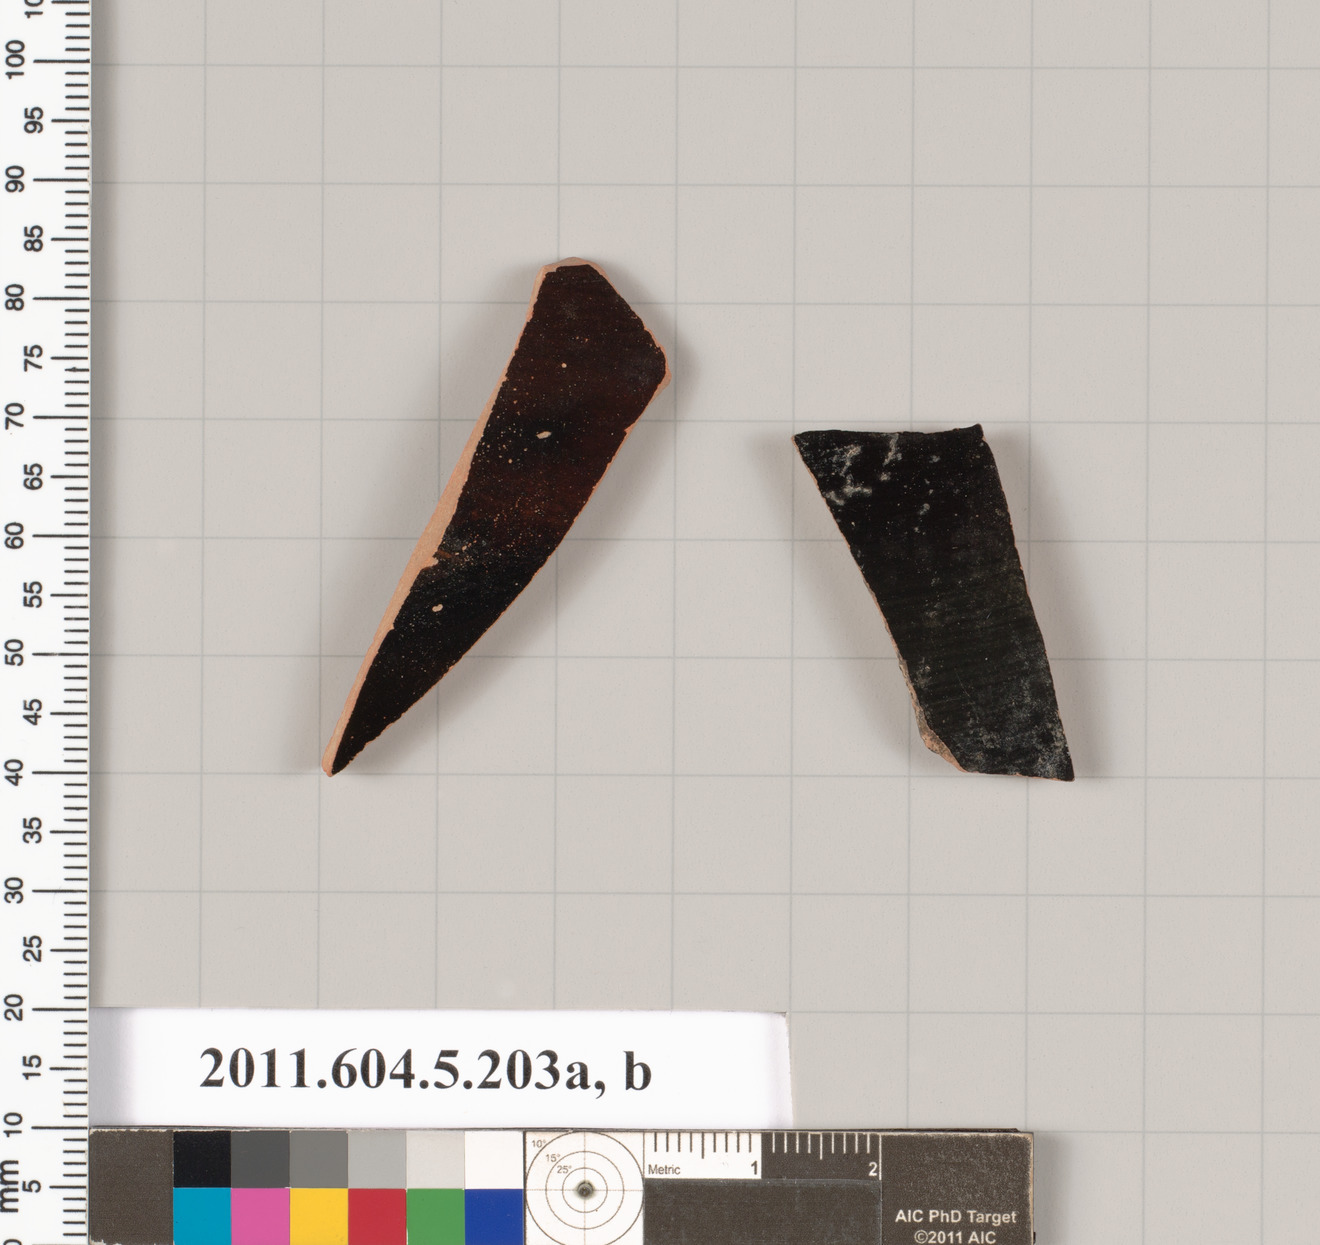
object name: kylix fragment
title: Terracotta fragments of kylikes (drinking cups)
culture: greek, attic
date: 600-401 BCE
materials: terracotta